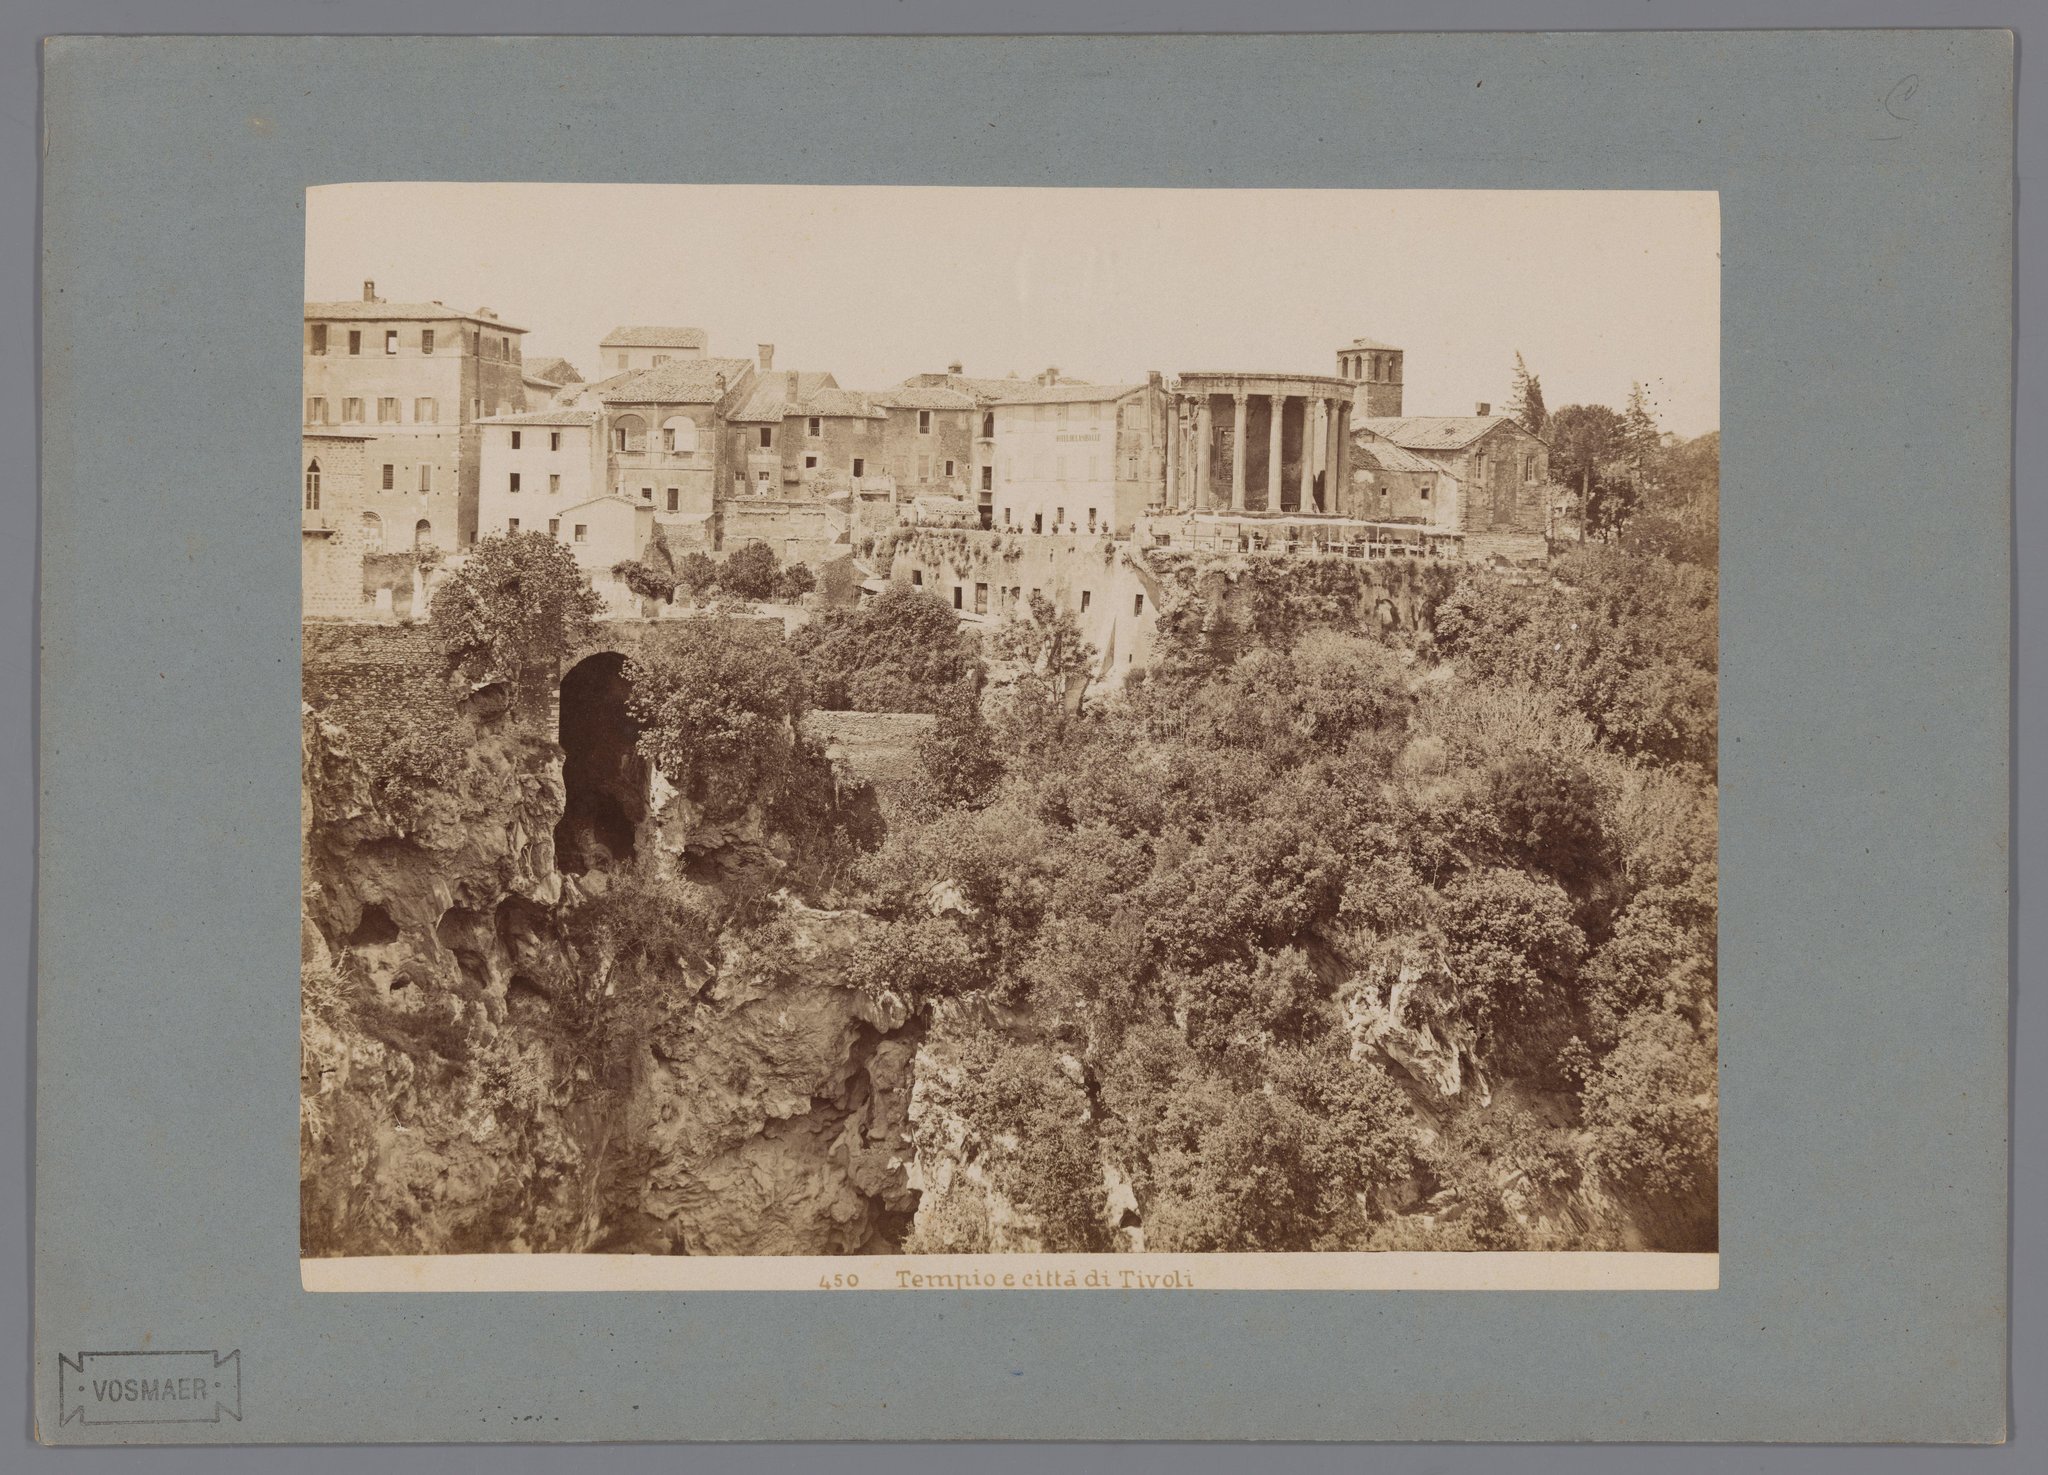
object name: photograph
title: Gezicht op Tivoli met de Tempel van Sibylle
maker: Anonymous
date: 1851-1900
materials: cardboard, paper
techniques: albumen print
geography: tivoli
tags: city-view in general; 'veduta', places and objects of worship ~ non-christian religions, tivoli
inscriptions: inscription: ‘doubl’, collector's mark: ‘VOSMAER’, number: ‘450’